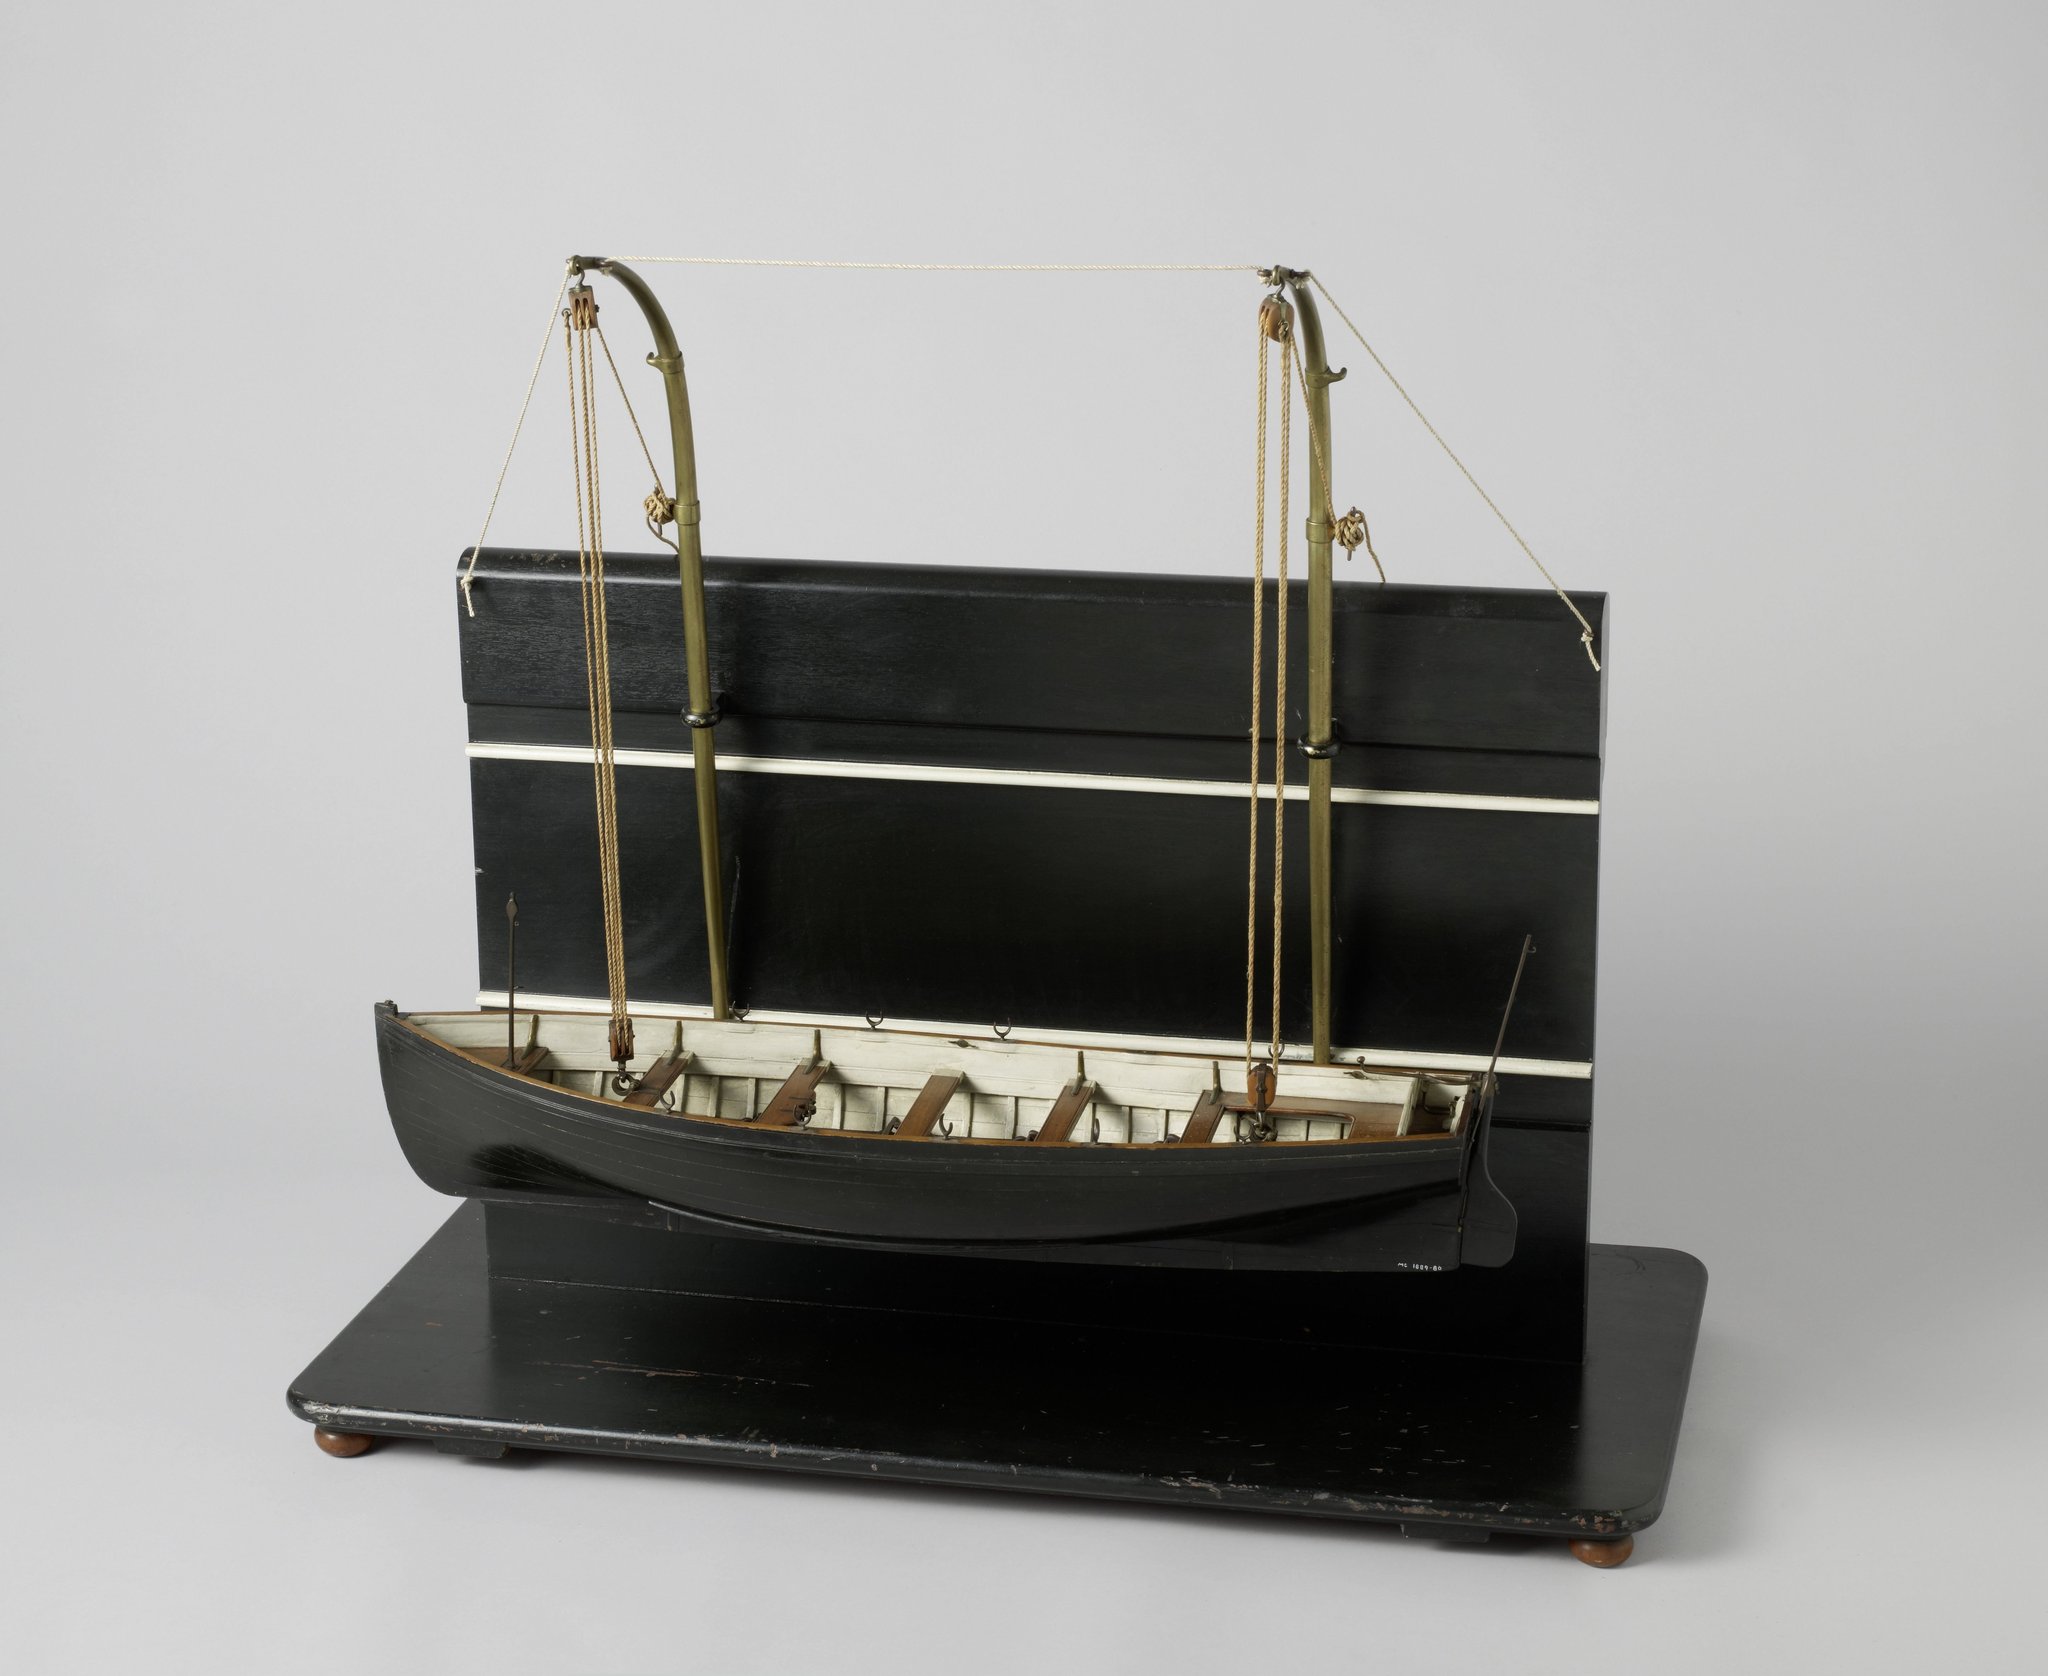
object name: demonstration model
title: Model of a Lifeboat Release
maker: Anonymous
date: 1875-1885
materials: brass, copper, fiber, wood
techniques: polychromy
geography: netherlands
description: Model van een deel van een scheepswand met een sloep aan twee spijkerdavits. Het model demonstreert de sloepsval in de bodem van de sloep, waarbij twee haken aan het takel van de davits worden losgelaten door middel van een hendel in de kajuit. De sloep is een gladboordige dubbelriems sloep met platte spiegel, de zeeg bijna vlak; hij heeft vier doften met spoorstokken, dollen voor acht roeiers en een open kajuit. Een aantal fittingen op het model blijft onduidelijk.